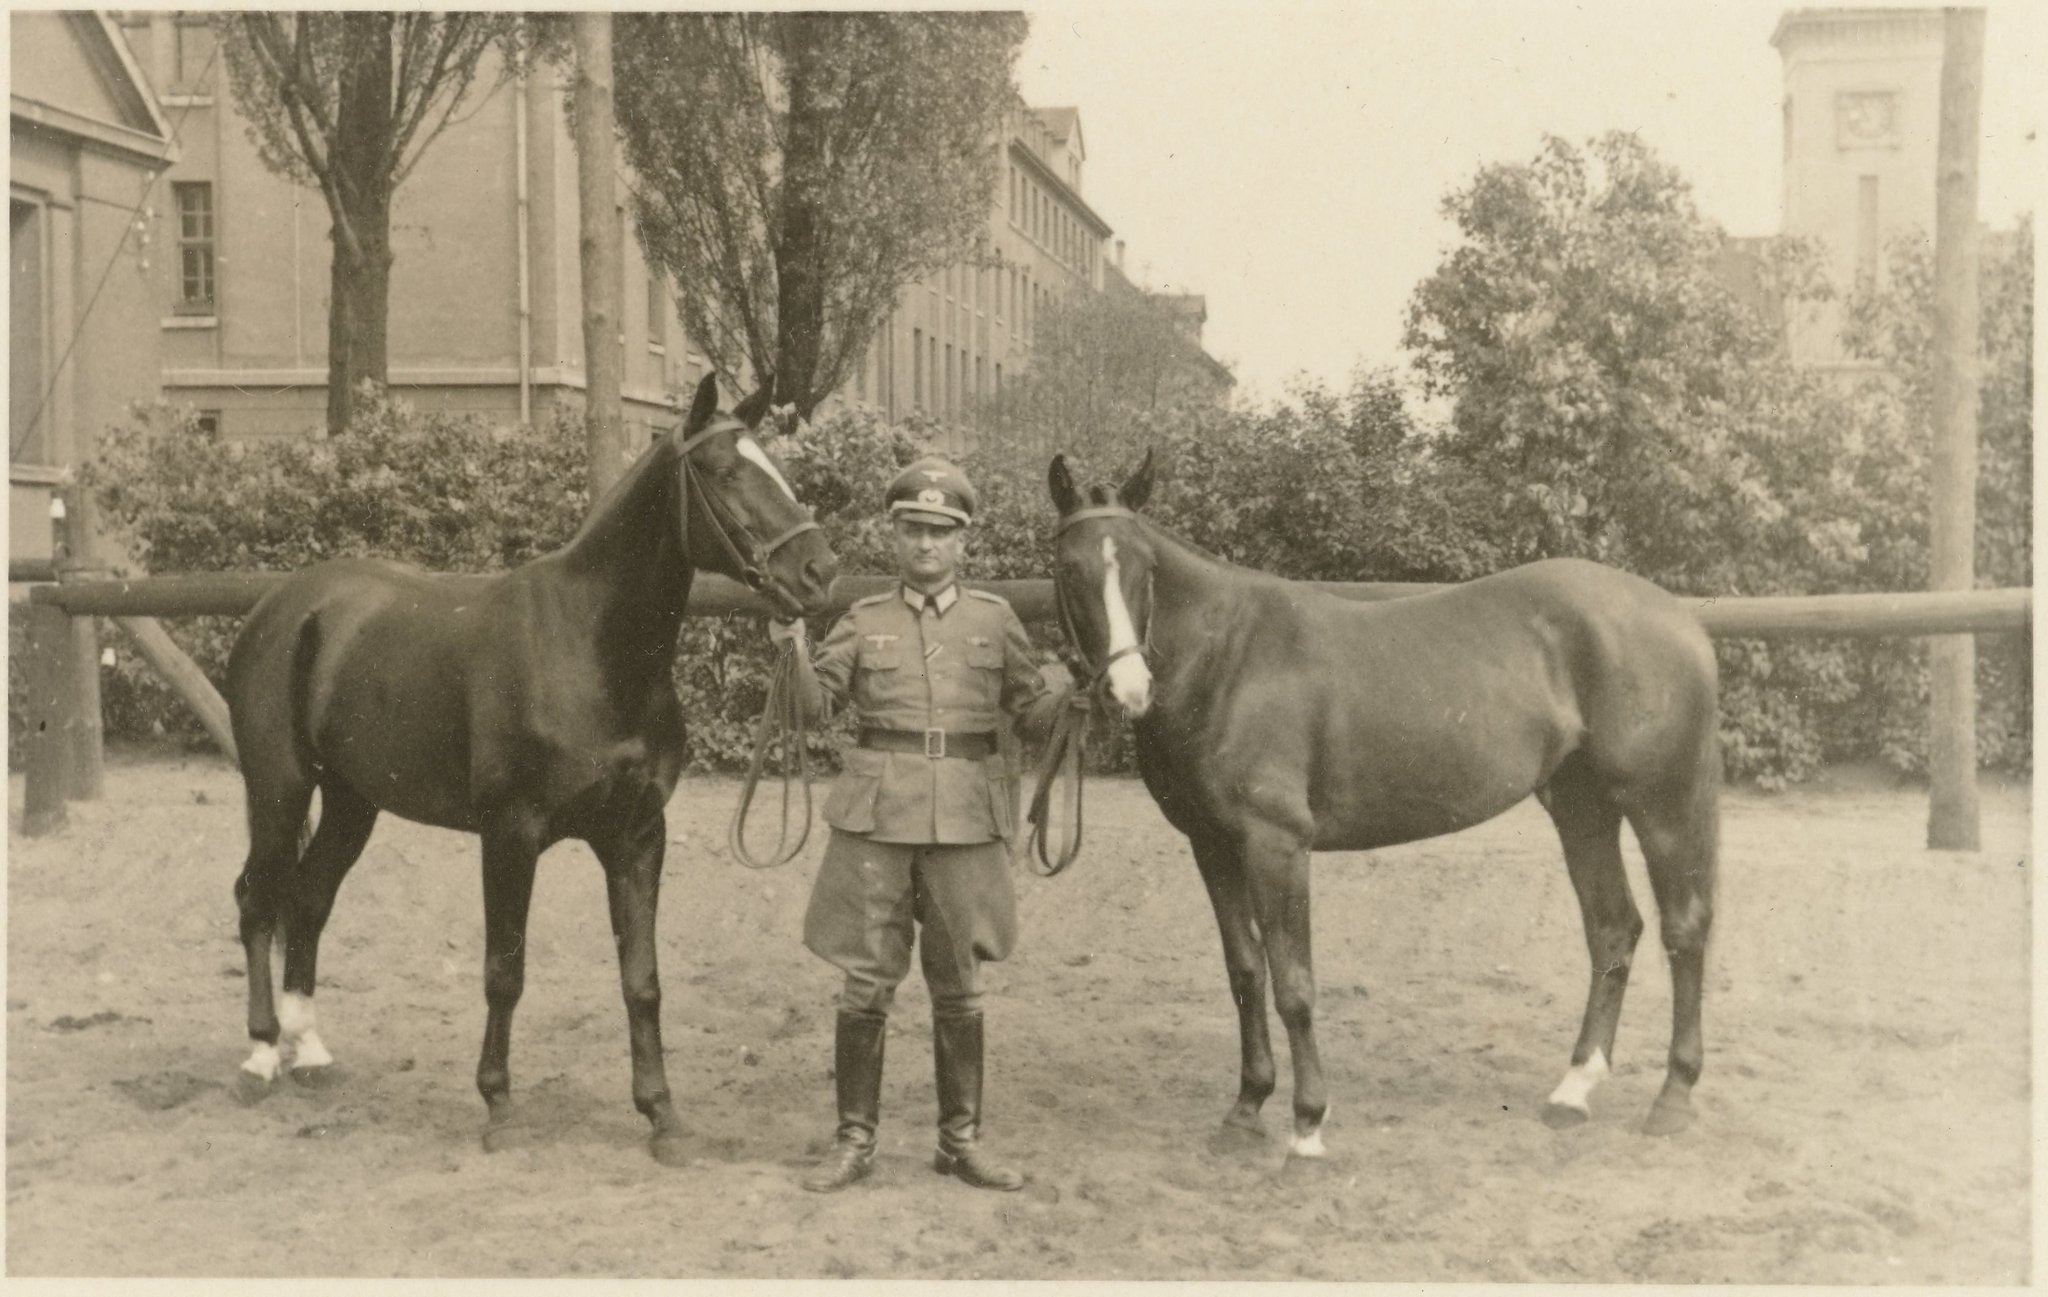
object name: photograph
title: Een Wehrmacht luitenant met twee paarden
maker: Anonymous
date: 1940-1945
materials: photographic support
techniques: gelatin silver print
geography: netherlands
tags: netherlands, germany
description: Een Wehrmacht luitenant die twee paarden bij de teugels vast houdt. Foto behorend bij album 'Kriegserinnerungen'.